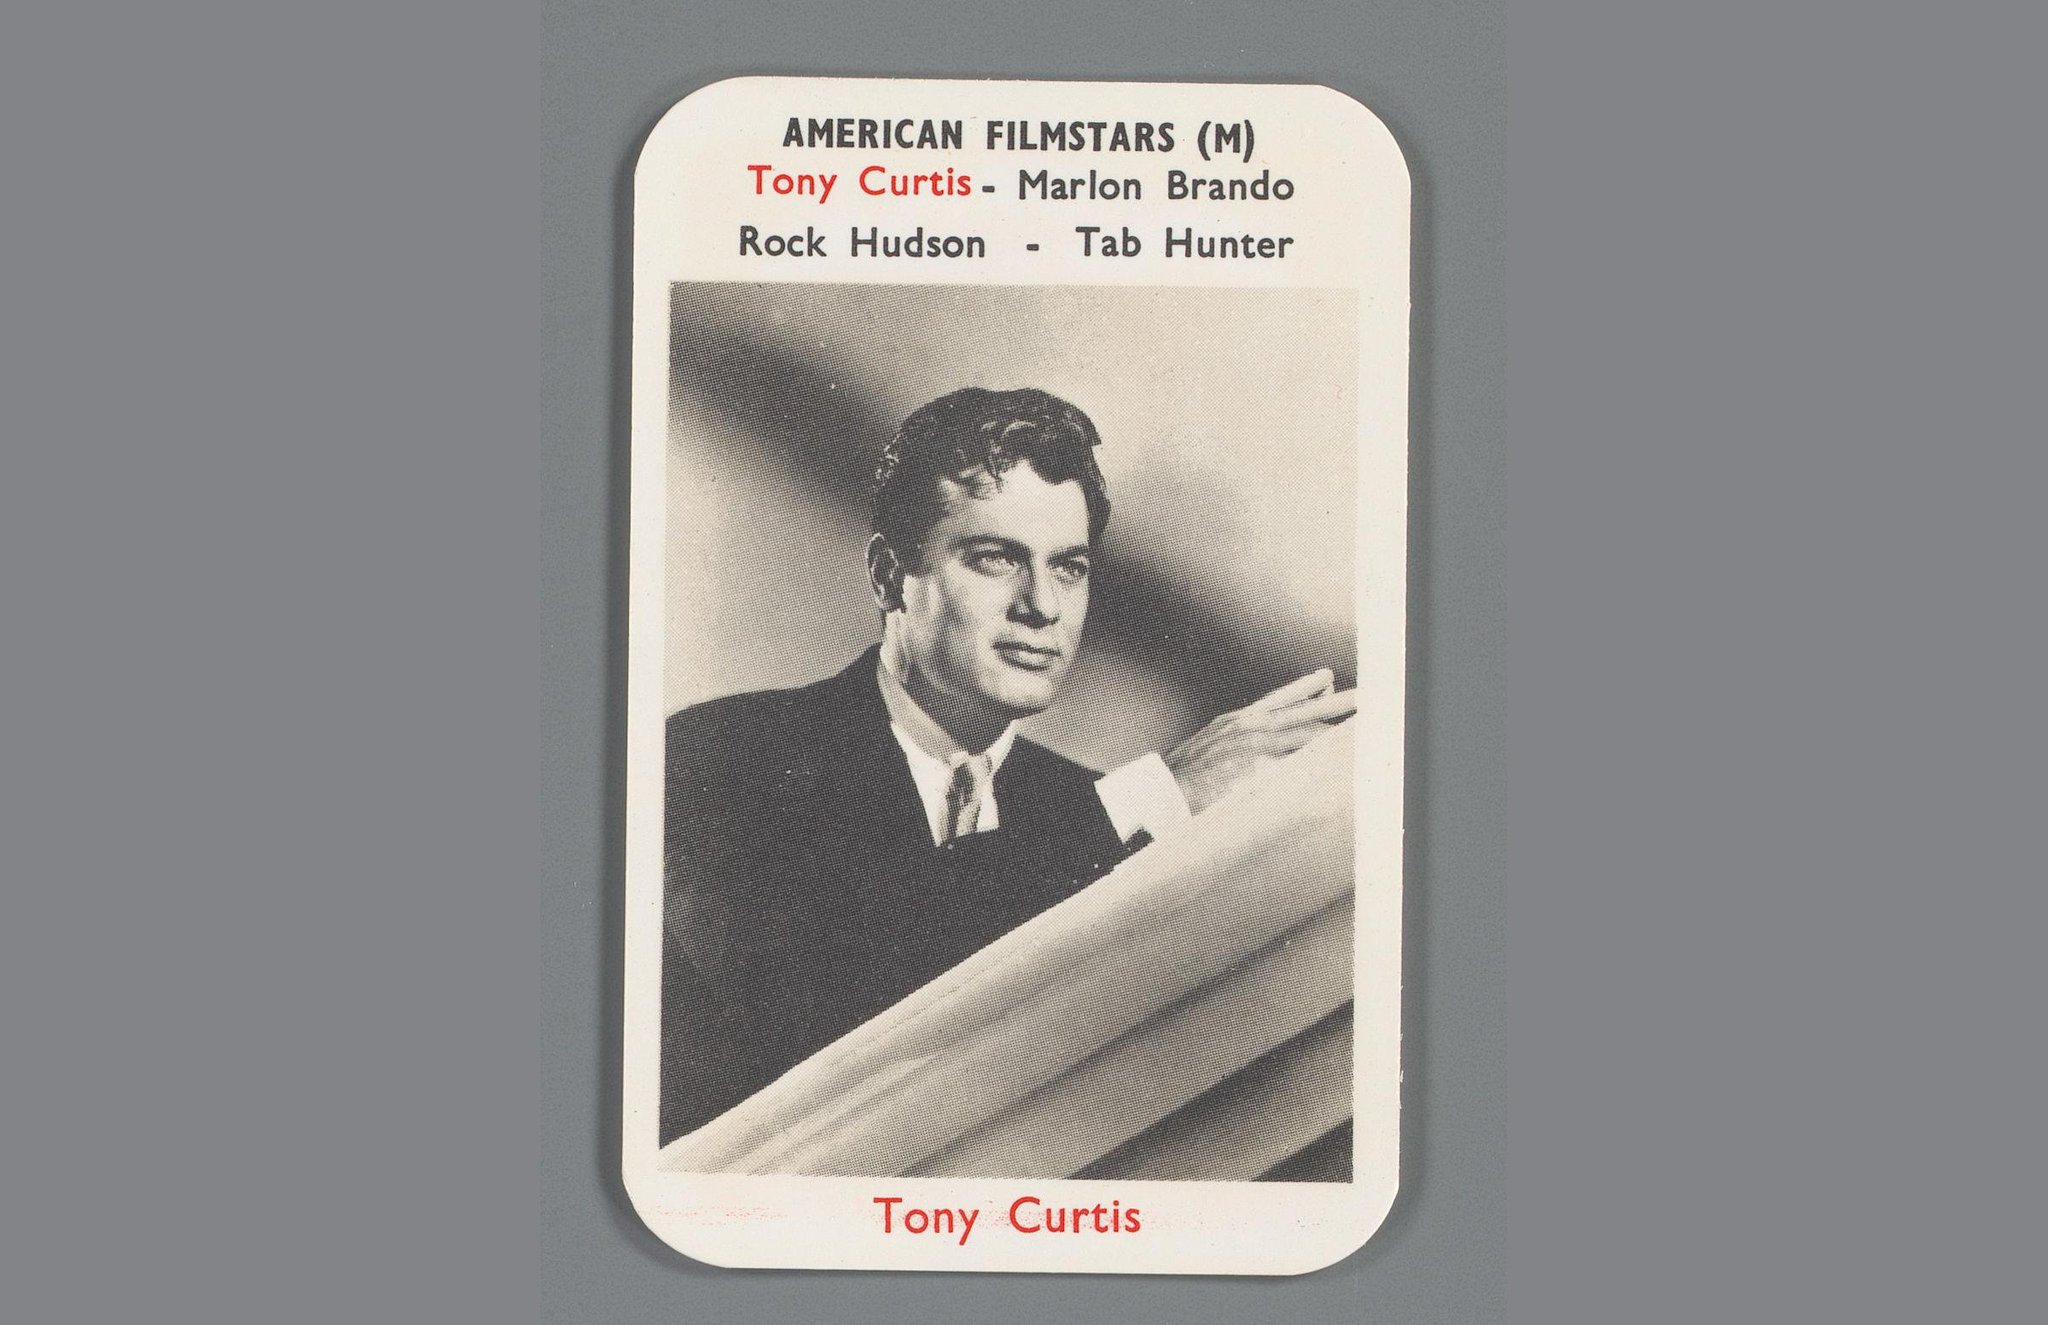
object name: photomechanical print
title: Tony Curtis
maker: Anonymous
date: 1960-1970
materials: paper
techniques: autotype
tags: new york (city), portrait of actor, actress